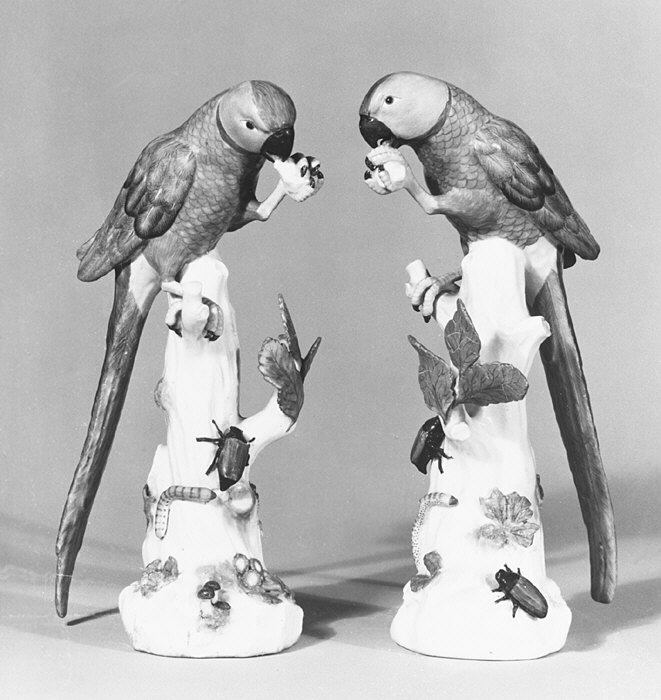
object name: figure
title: Indian parrot (one of a pair)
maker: meissen manufactory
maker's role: manufactory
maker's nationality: german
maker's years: 1710-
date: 1741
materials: hard paste porcelain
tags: parrots,insects,leaves